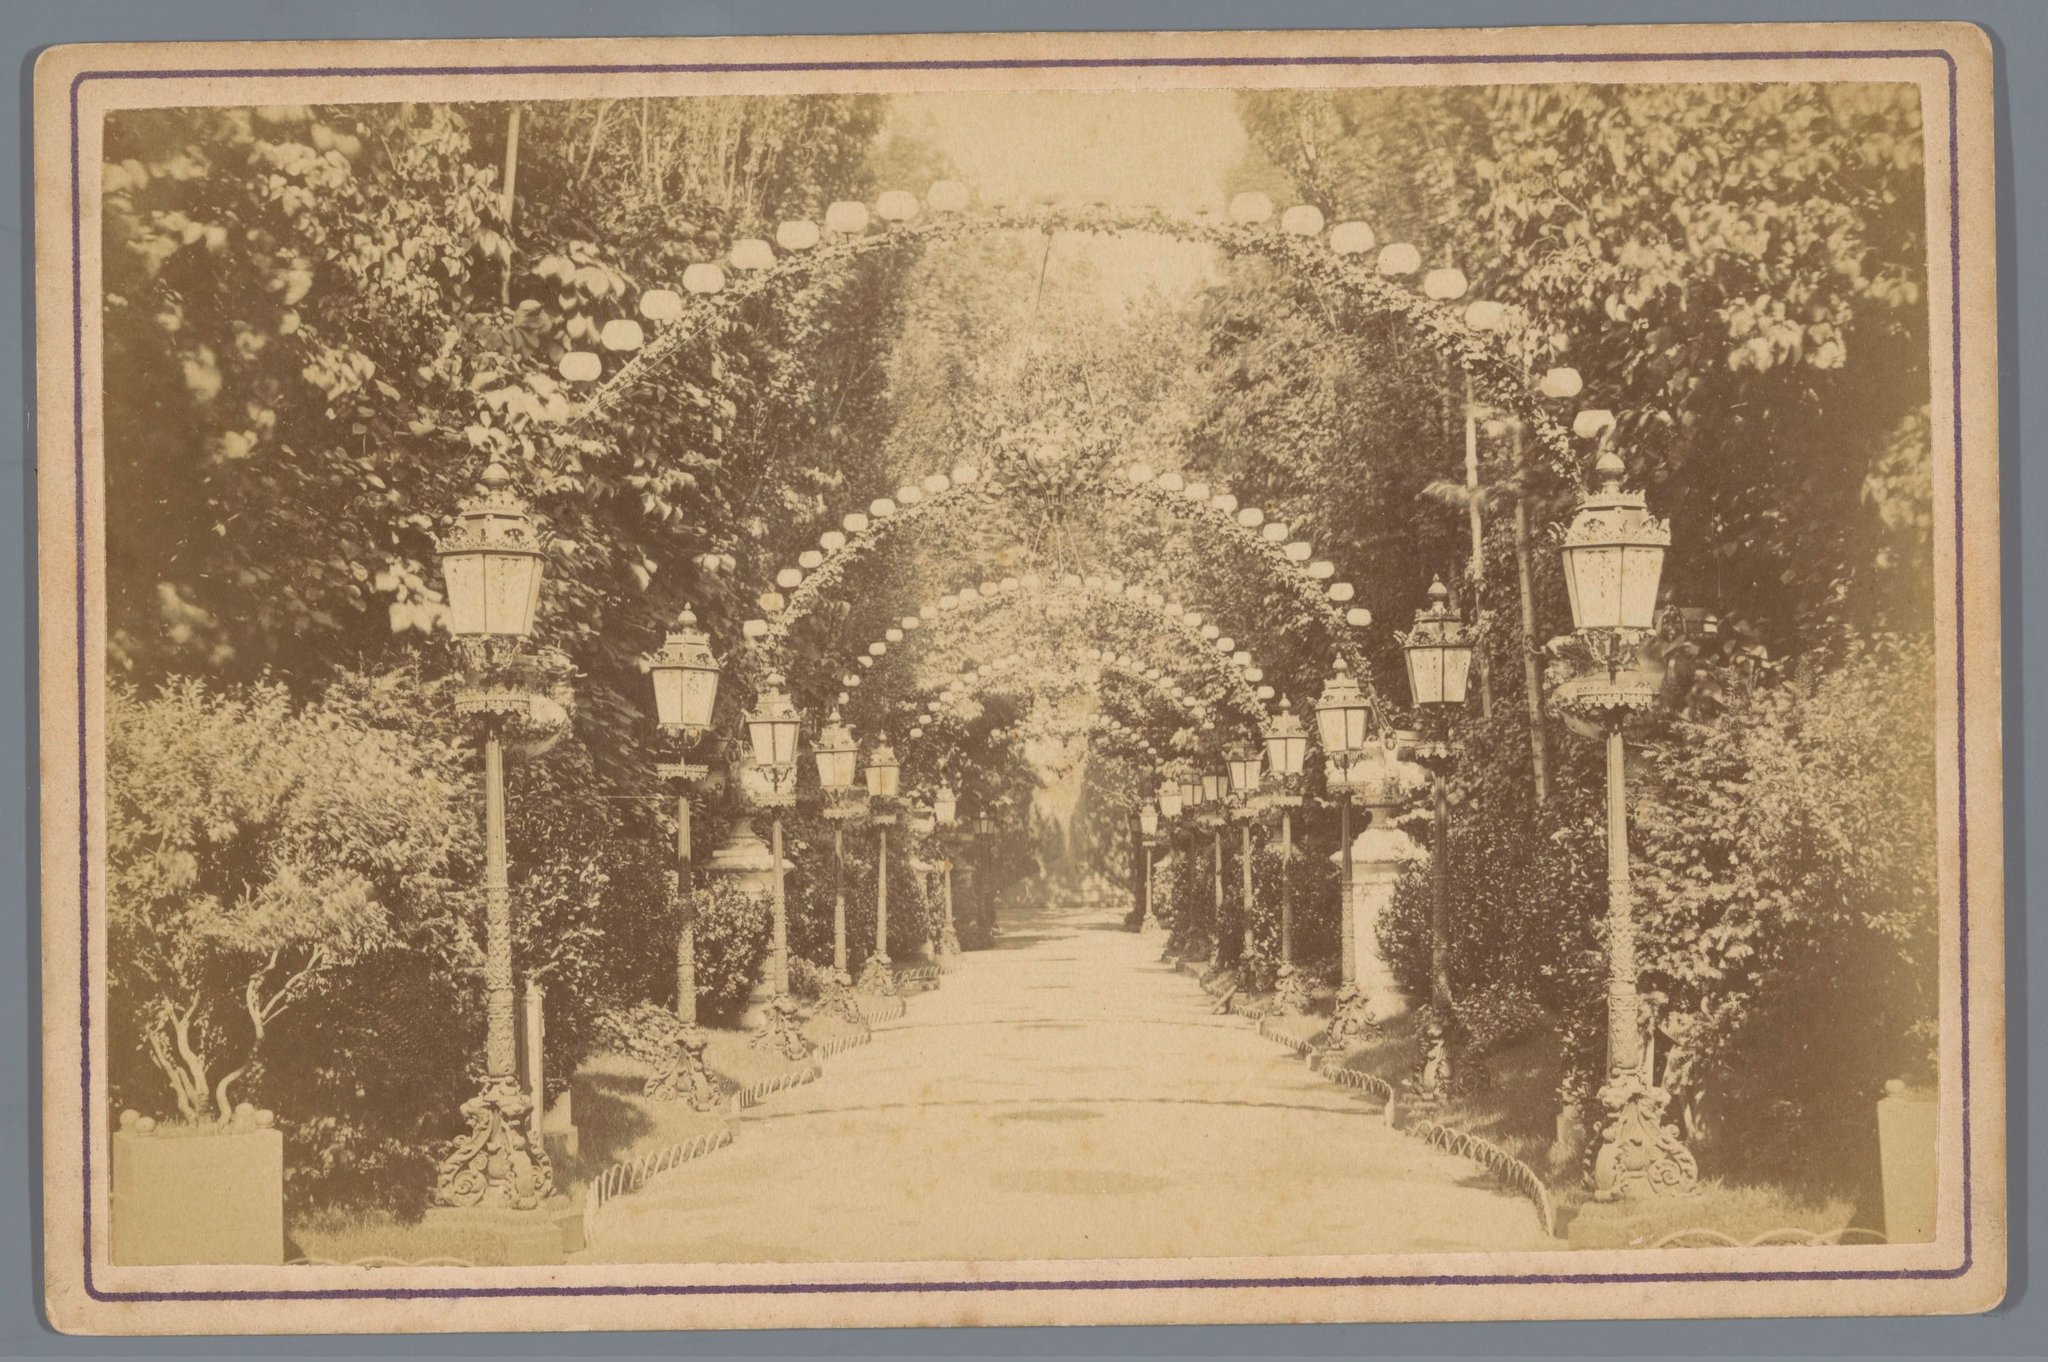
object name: cabinet photograph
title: Laan in de Jardin Mabille te Parijs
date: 1865-1875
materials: cardboard, photographic support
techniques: albumen print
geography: france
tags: forest path or lane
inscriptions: inscription: ‘Compagnie Photographique Debitte & Hervé 170, Rue de Rivoli, Paris’, inscription: ‘Jardin Mabille’